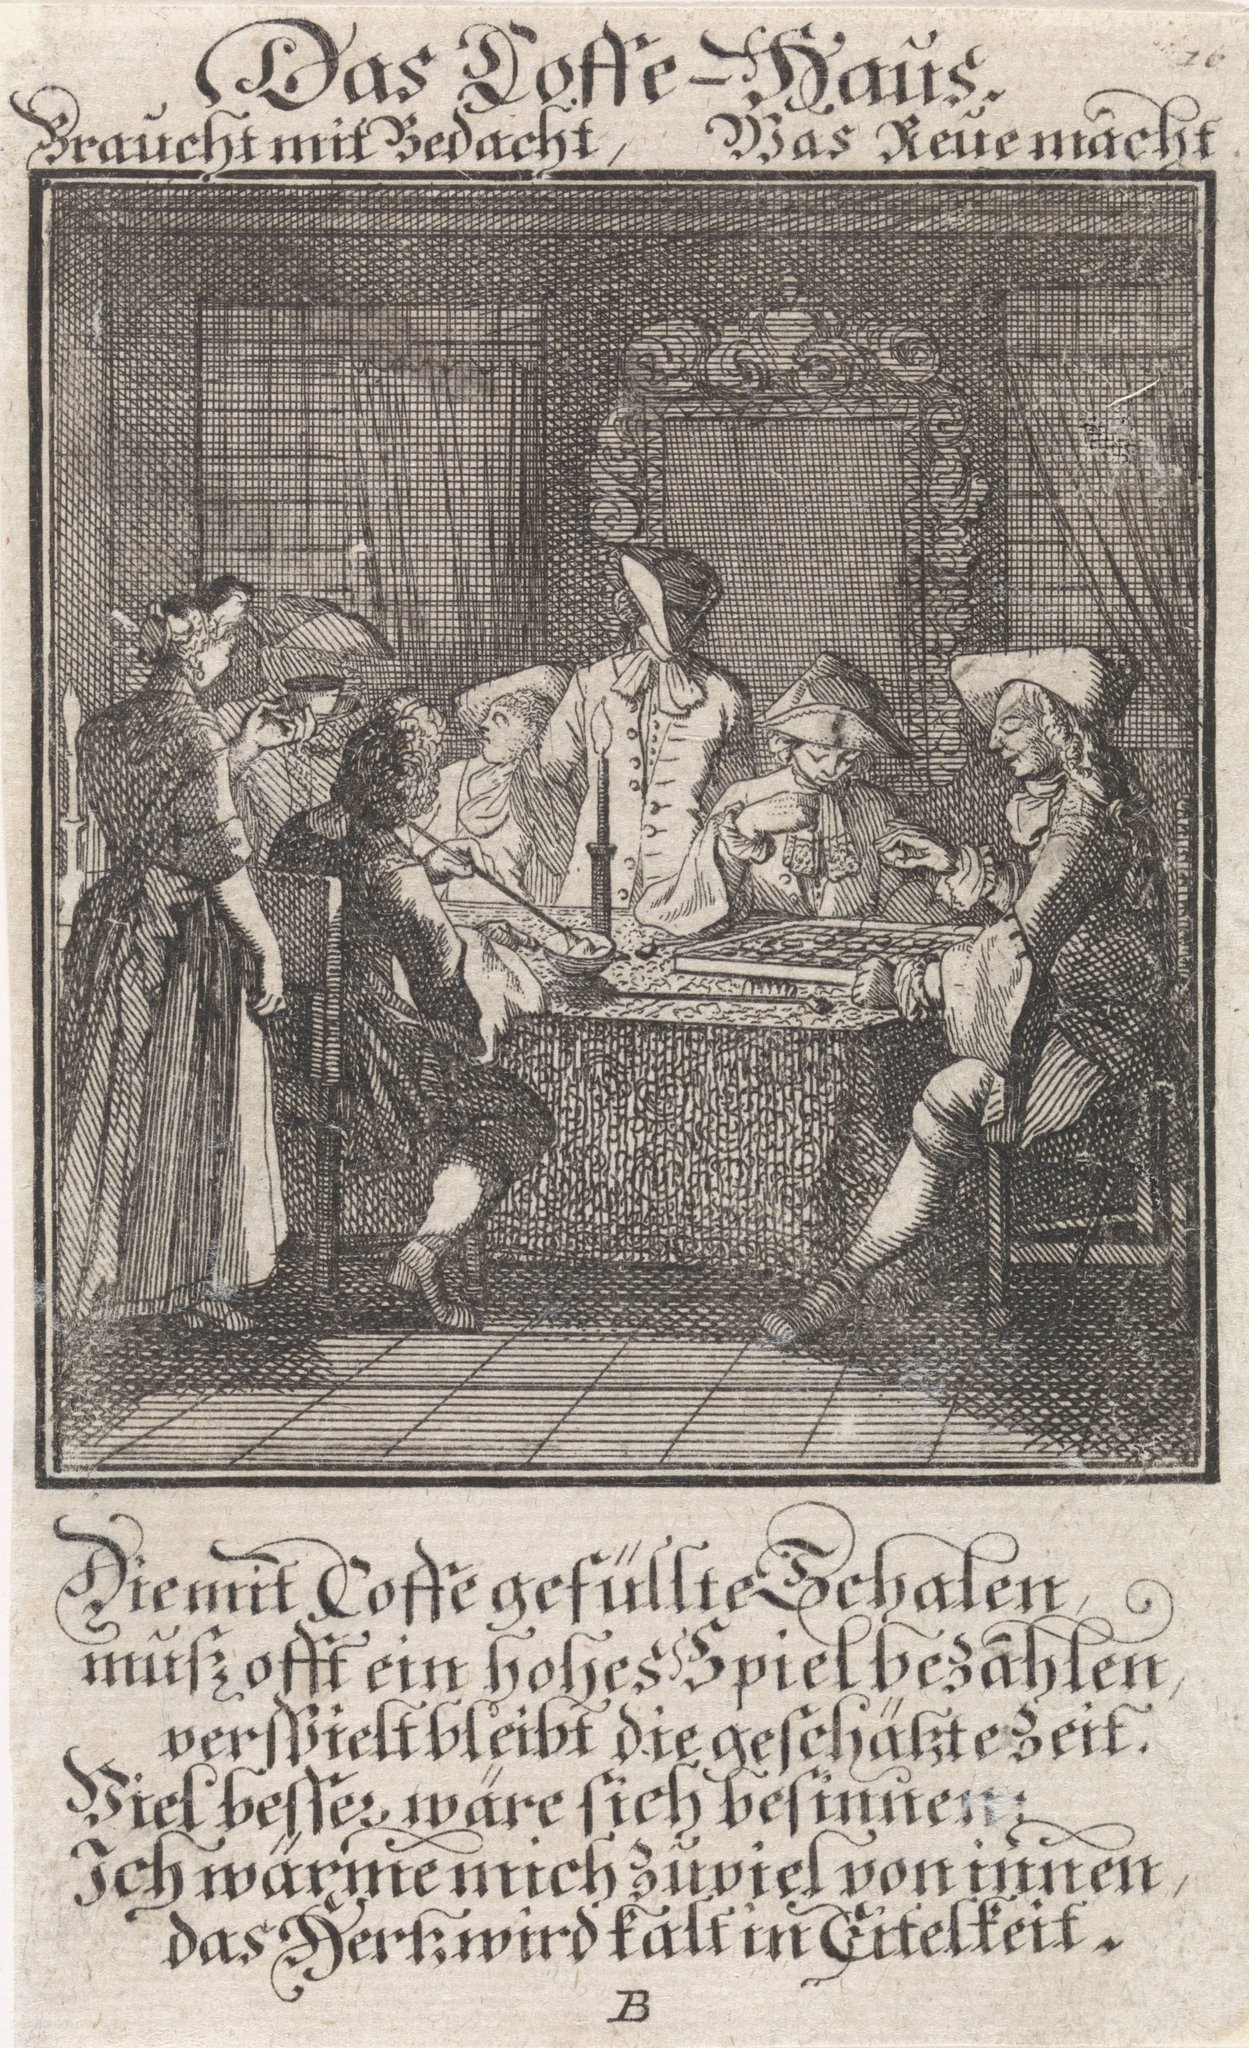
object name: book illustration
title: Koffiehuis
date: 1711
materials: paper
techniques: etching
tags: inn, coffee-house, public house, etc.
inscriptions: collector's mark: Lugt 2228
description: Illustratie uit: Sancta Clara, Abraham à. Etwas für Alle, das ist: Eine kurtze Beschreibung allerley Stands- Ambts- und Gewerbs-Persohnen (...), 3 delen (1699-1733). Würtzburg: Martin Frank Hertz, 1711, dl. II, p. 152. Het betreft hier de tweede druk van deel II.